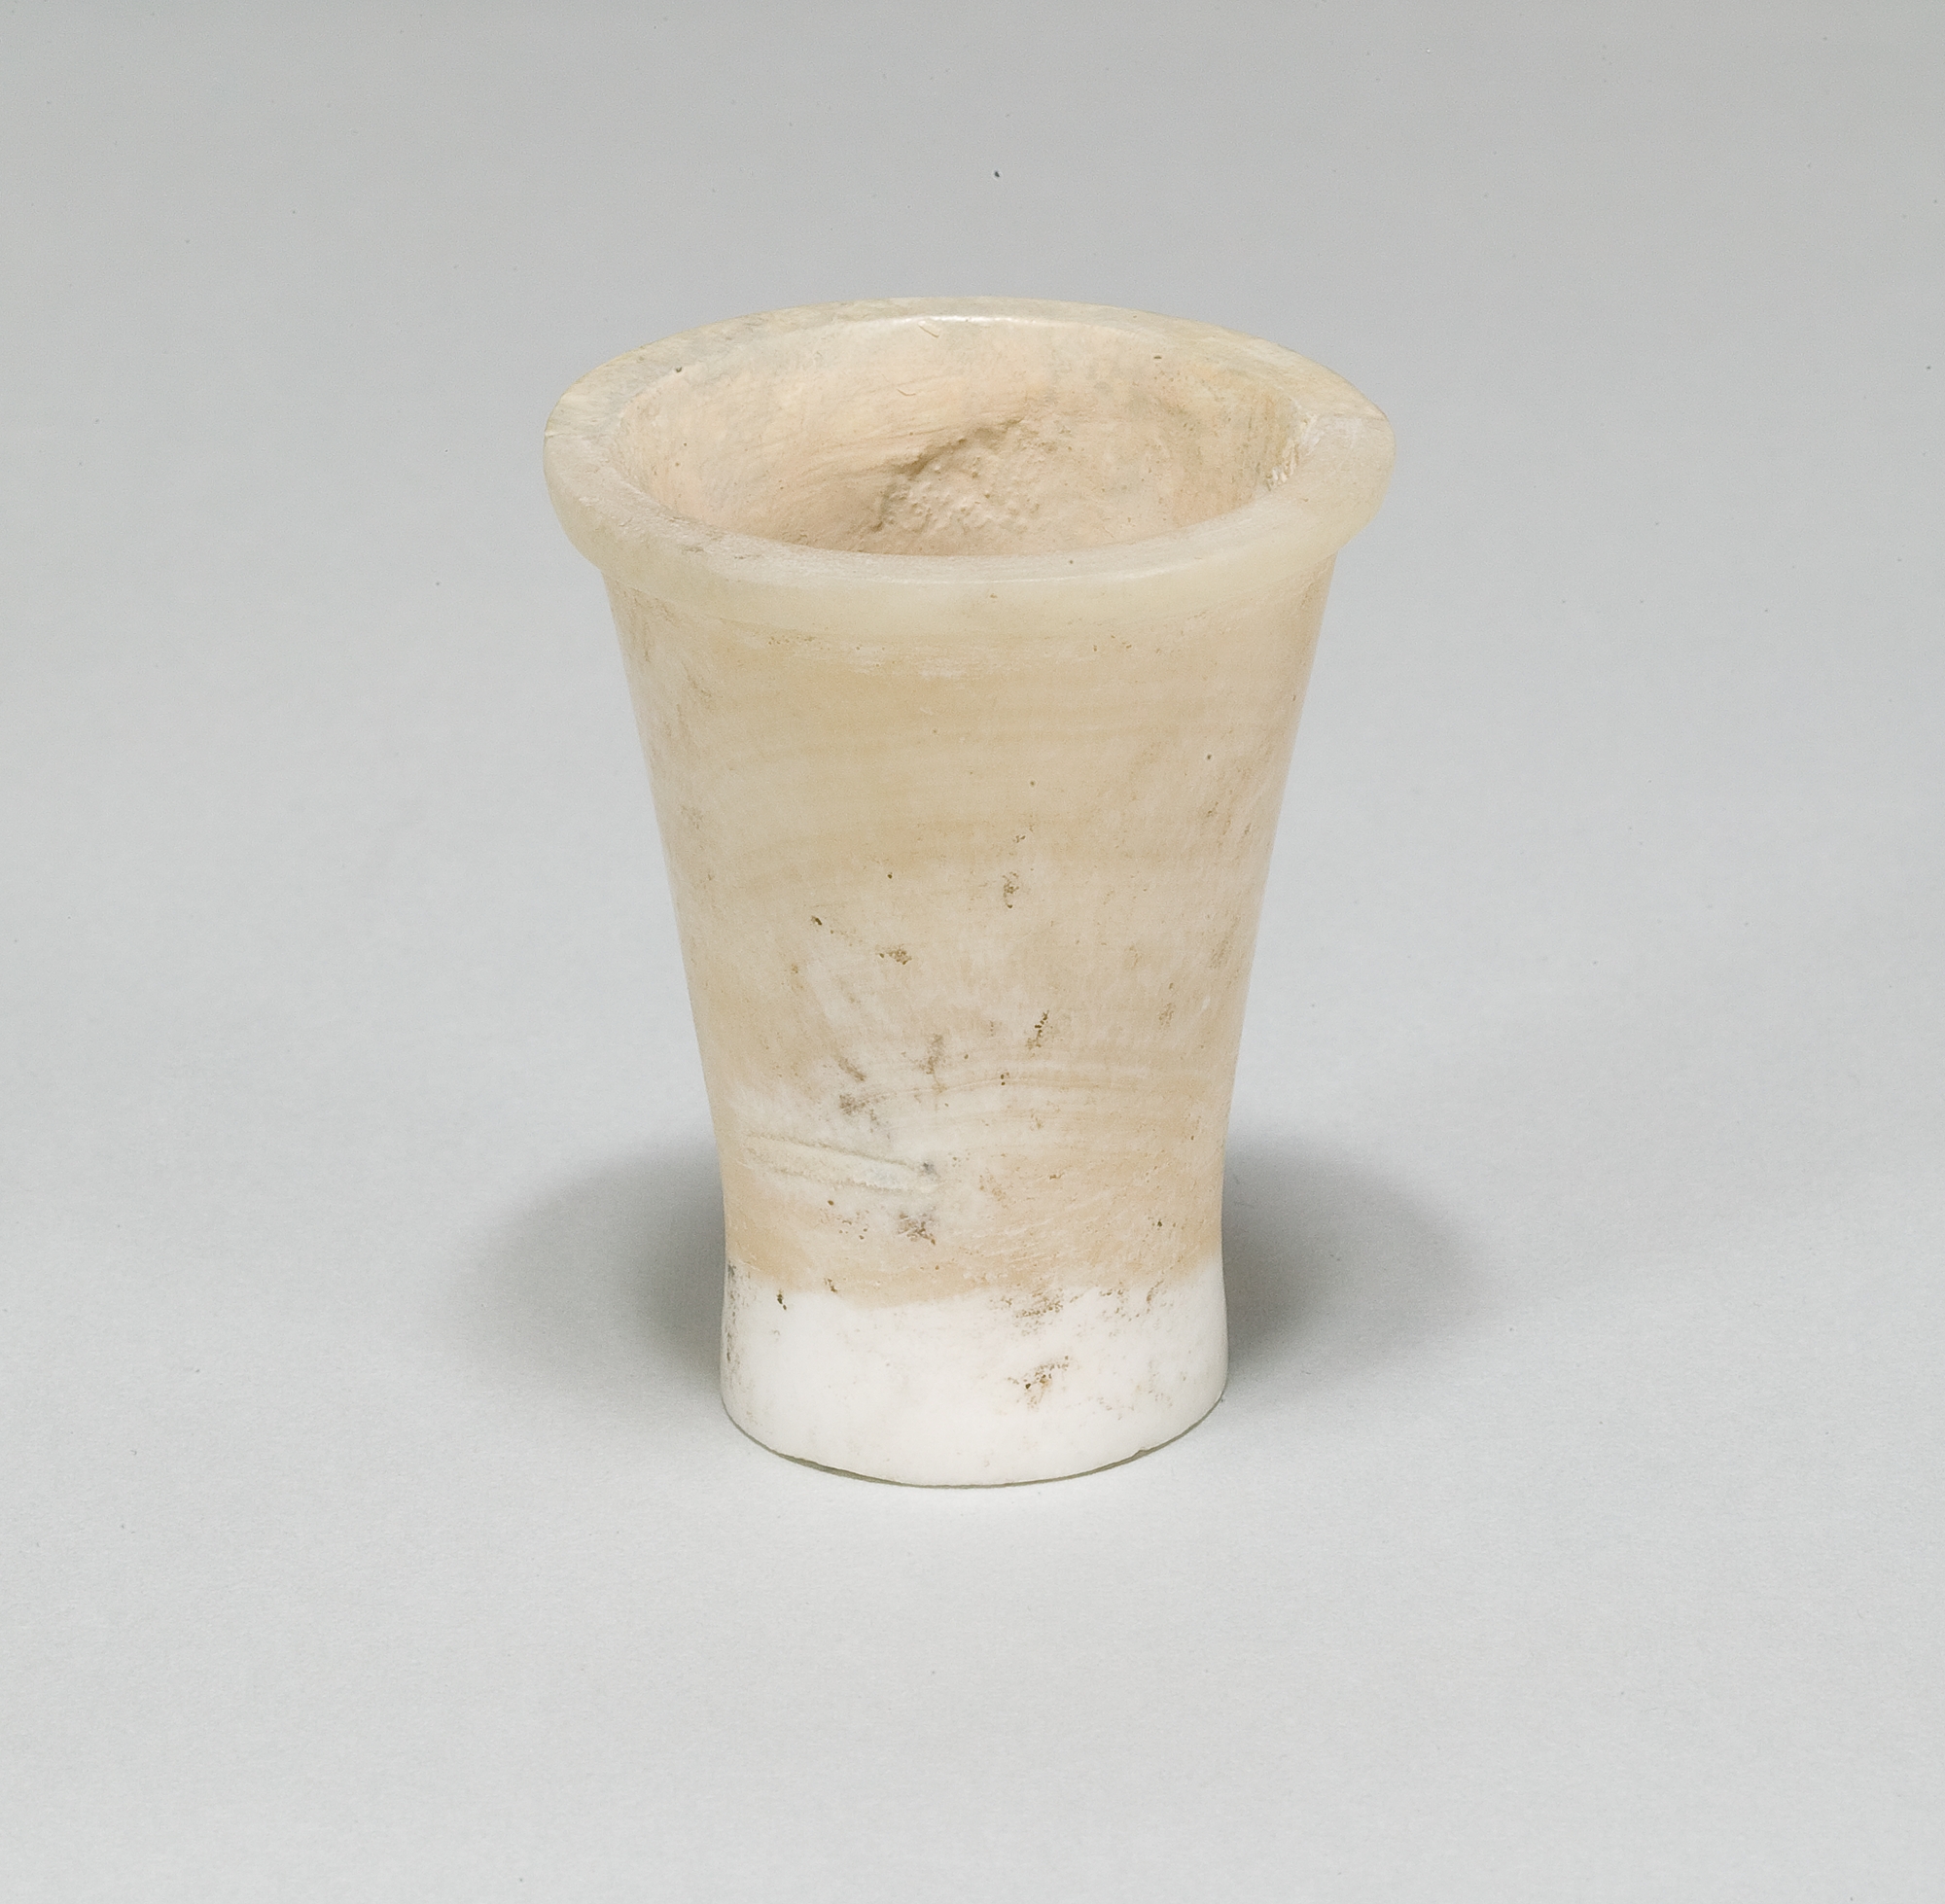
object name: miniature ointment jar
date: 1850-1775 BCE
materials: stone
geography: egypt